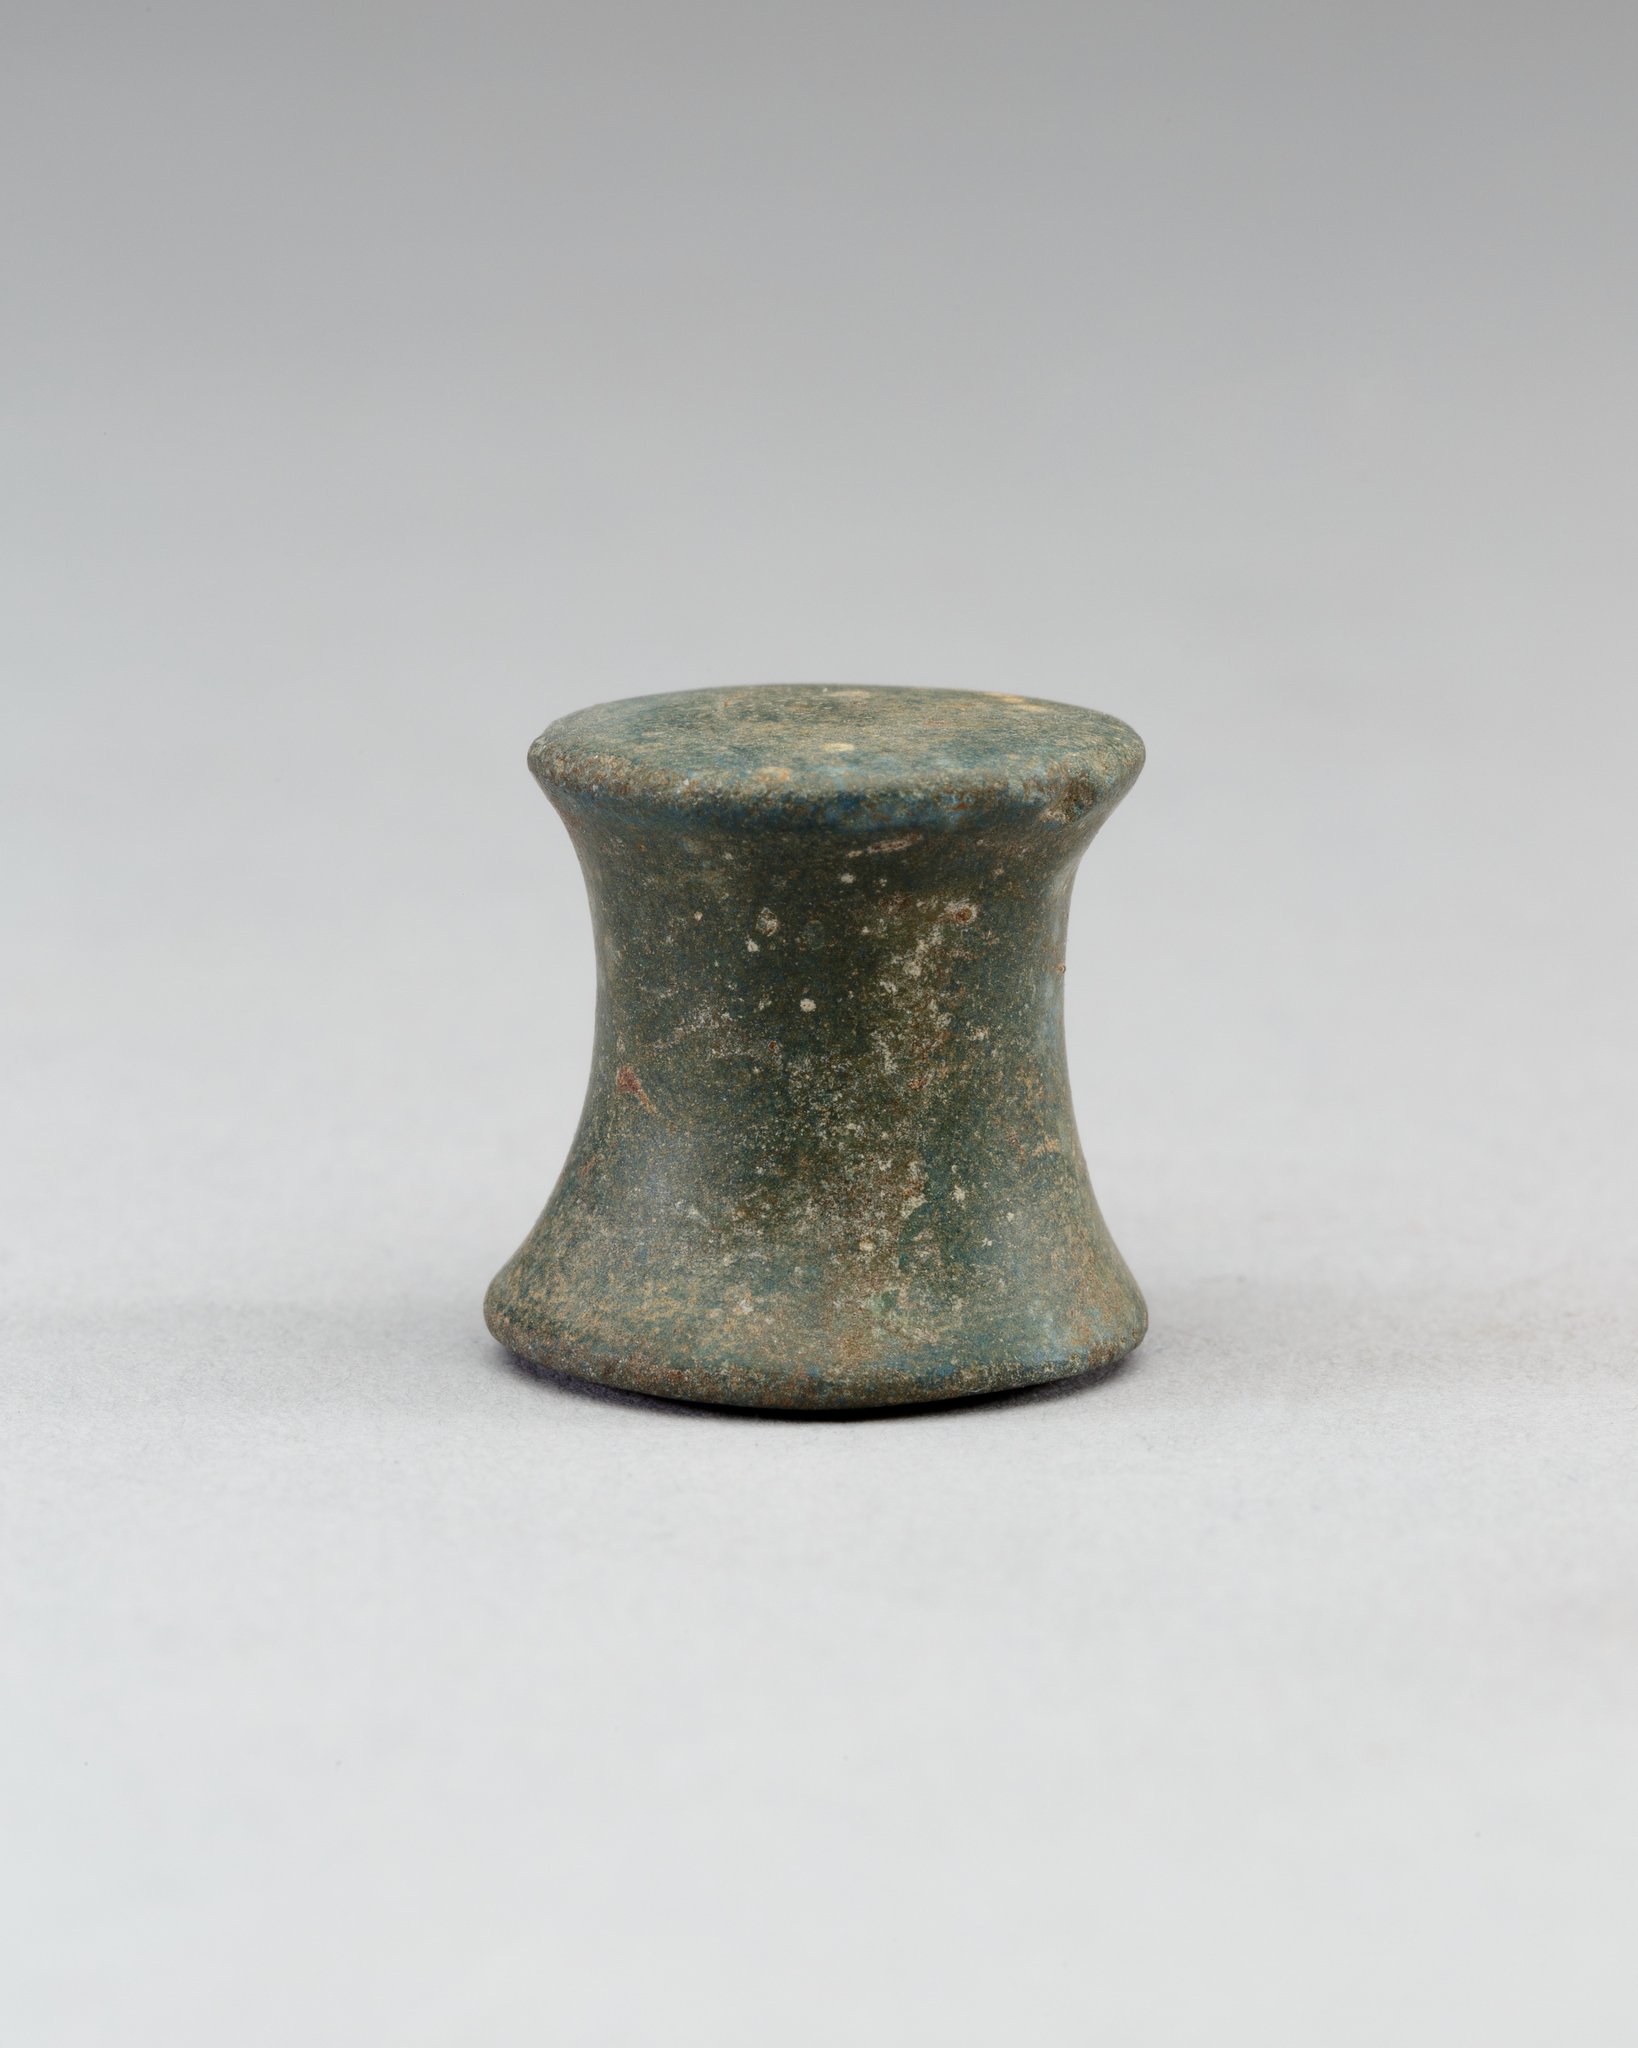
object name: game piece, spool, burial 8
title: Spool-Shaped Game Pieces from Neferkhawet's Tomb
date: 1504-1447 BCE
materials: faience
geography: egypt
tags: games